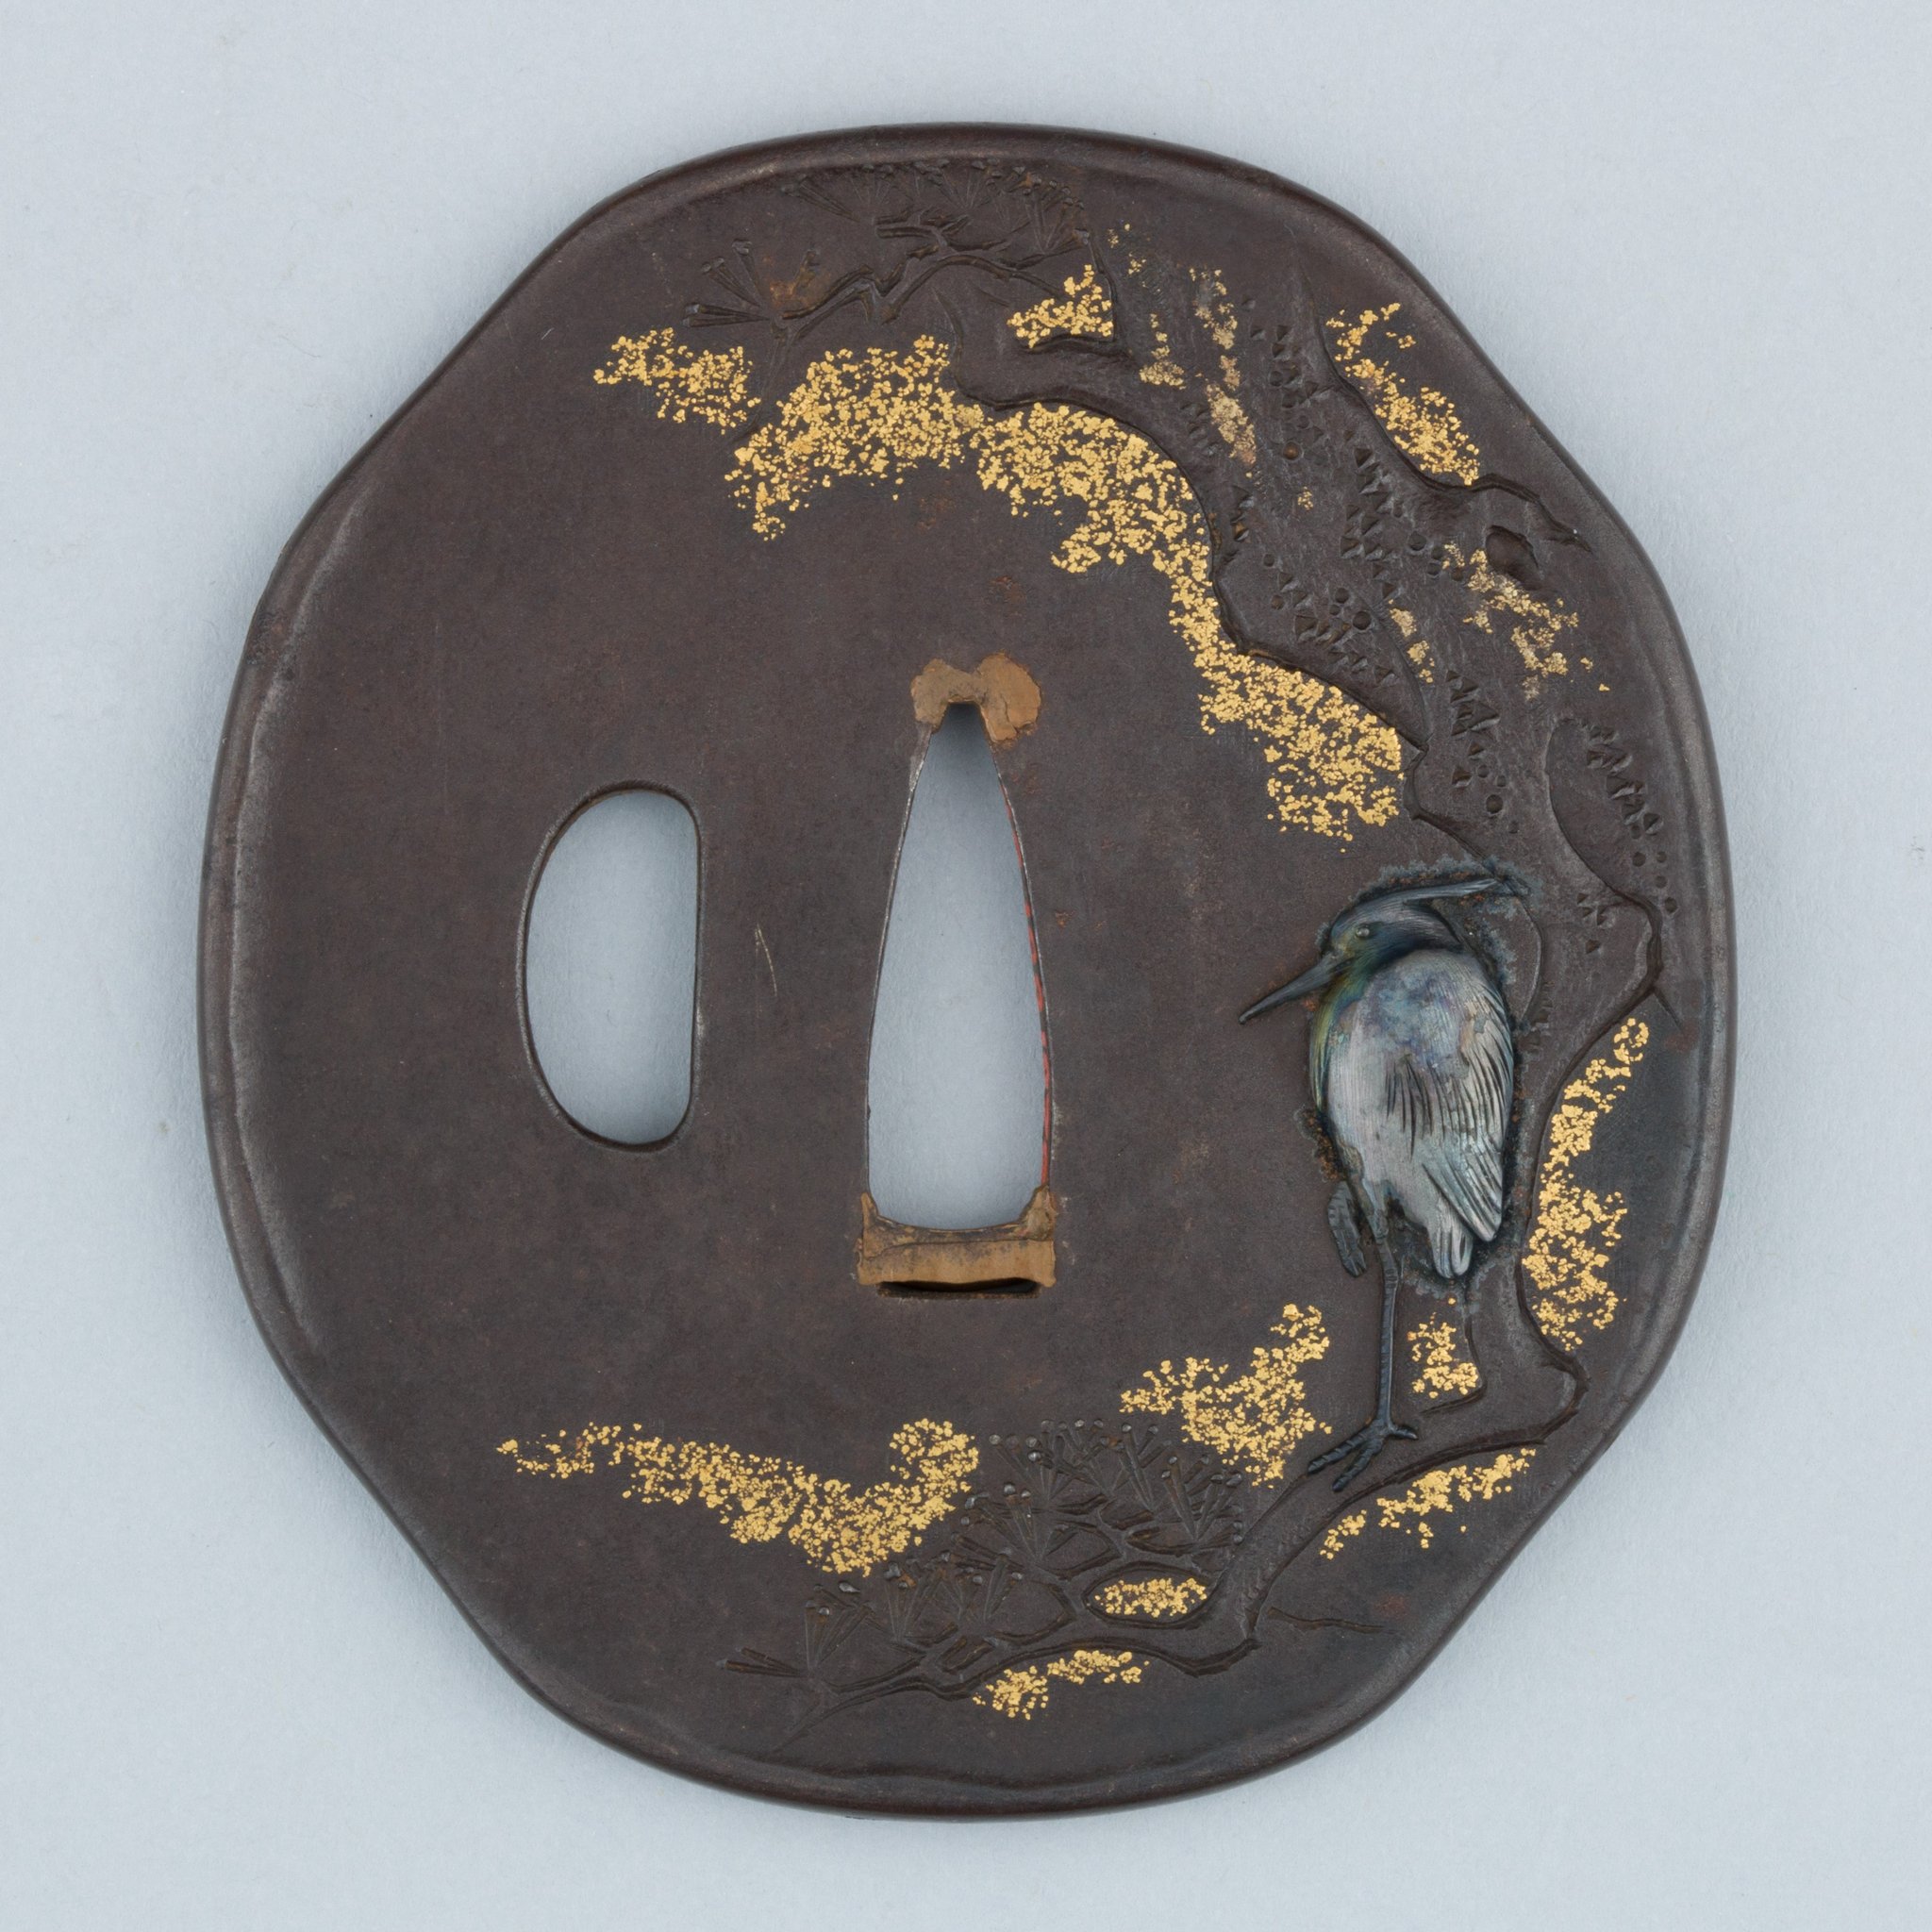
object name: sword guard tsuba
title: Sword Guard (Tsuba)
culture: japanese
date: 1615-1868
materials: copper, gold alloy, gold, iron, silver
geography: japan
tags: birds